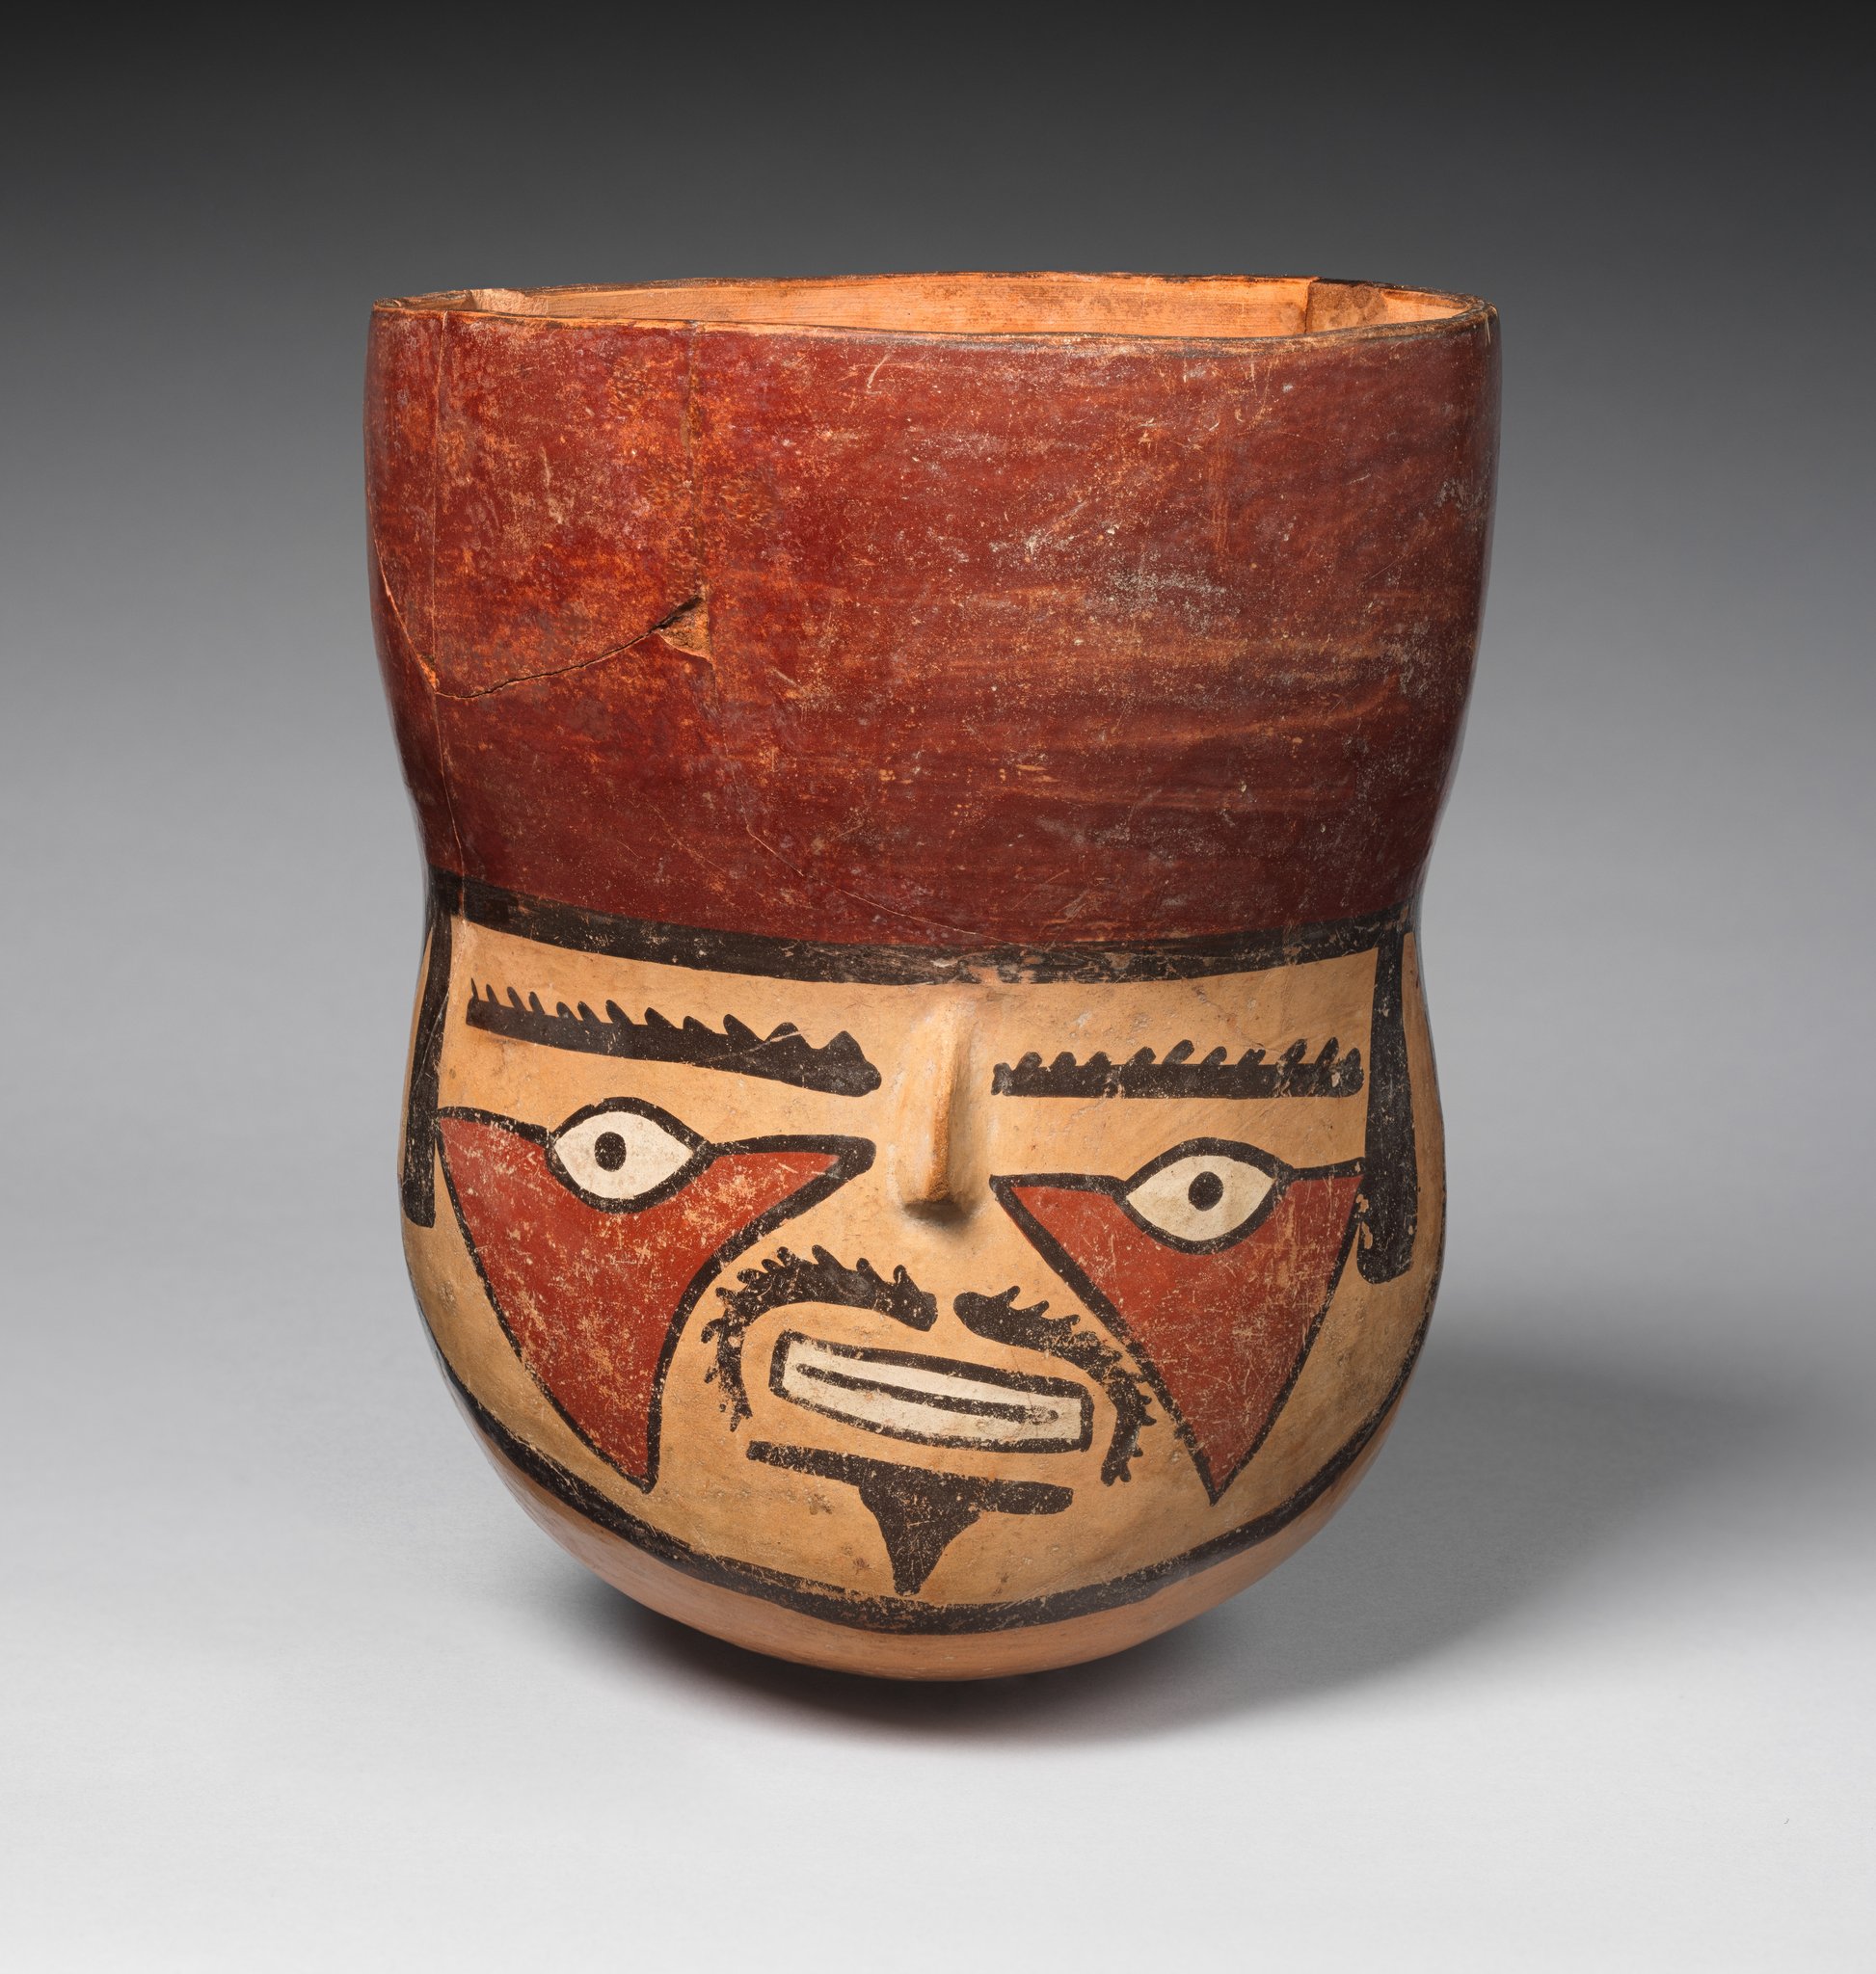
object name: jar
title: Head jar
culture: nasca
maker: nasca artist(s)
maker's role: artist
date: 100-500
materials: ceramic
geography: peru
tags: heads